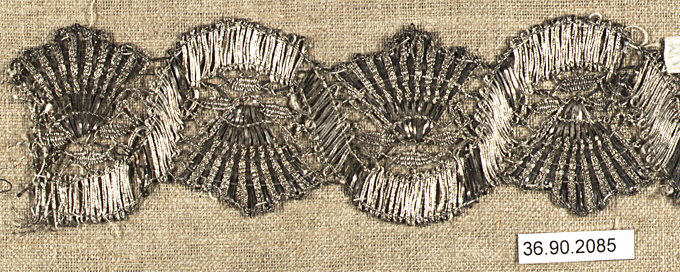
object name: piece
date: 1701-1800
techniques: lace